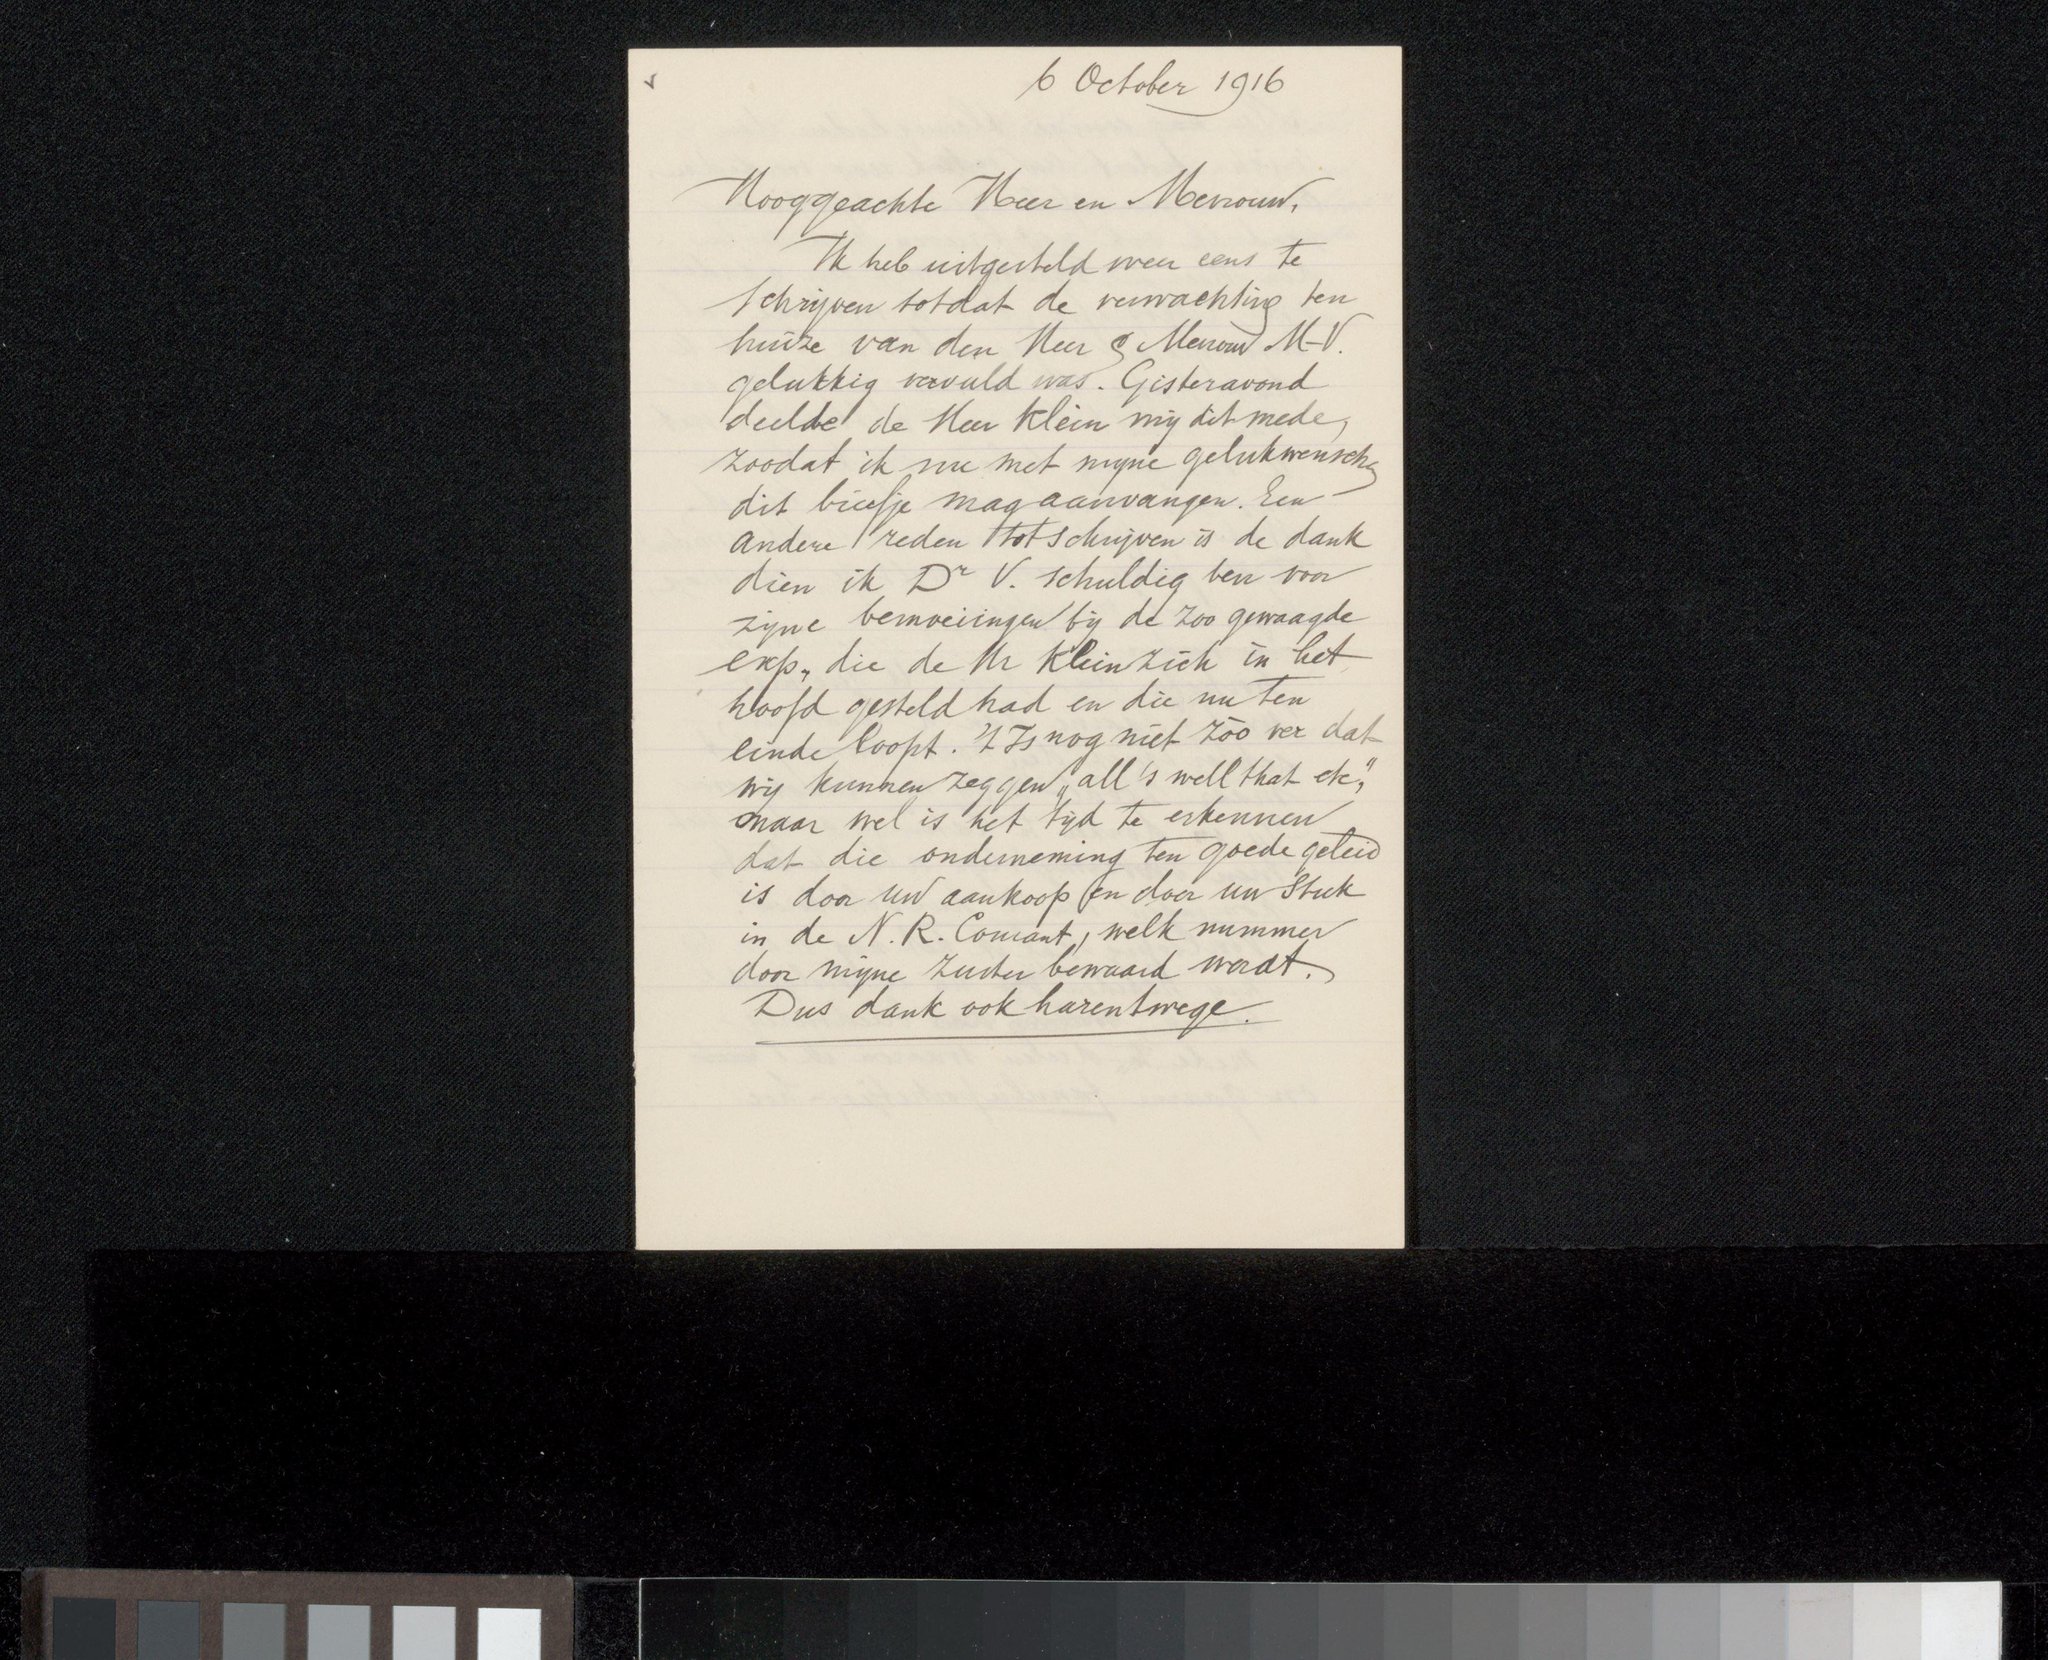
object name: letter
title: Brief aan Jan Veth en Anna Dorothea Dirks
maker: august allebé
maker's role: draughtsman, print maker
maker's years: 1838-1927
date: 1916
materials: ink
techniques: pen, writing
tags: dordrecht, amsterdam, painter, print maker, draughtsman, designer, jan veth, den bosch, antoon derkinderen, artist, anna dorothea dirks, daniël franken dzn., the graphic arts, anonymous historical person portrayed, painting (including book-illumination, miniature-painting)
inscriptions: collector's mark: ‘RPK’